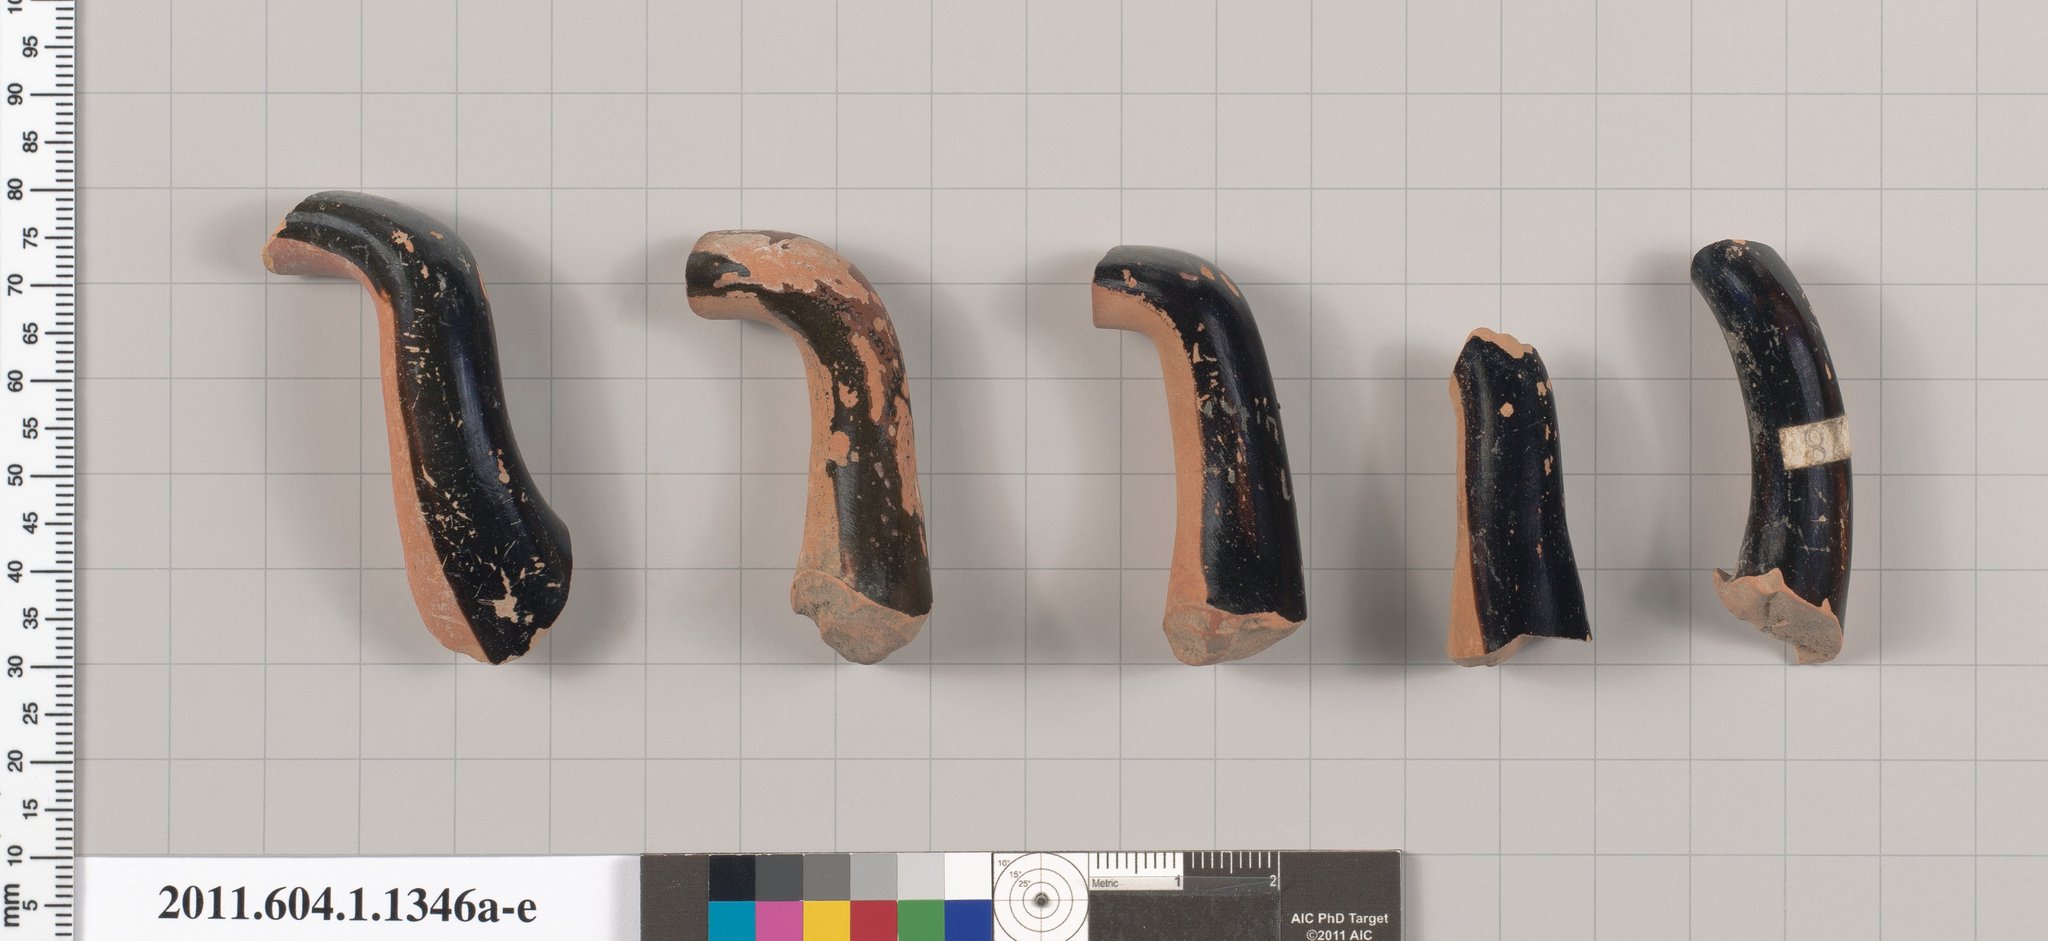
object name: kylix fragment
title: Terracotta fragments of kylikes (drinking cups)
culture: greek, attic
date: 500-401 BCE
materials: terracotta